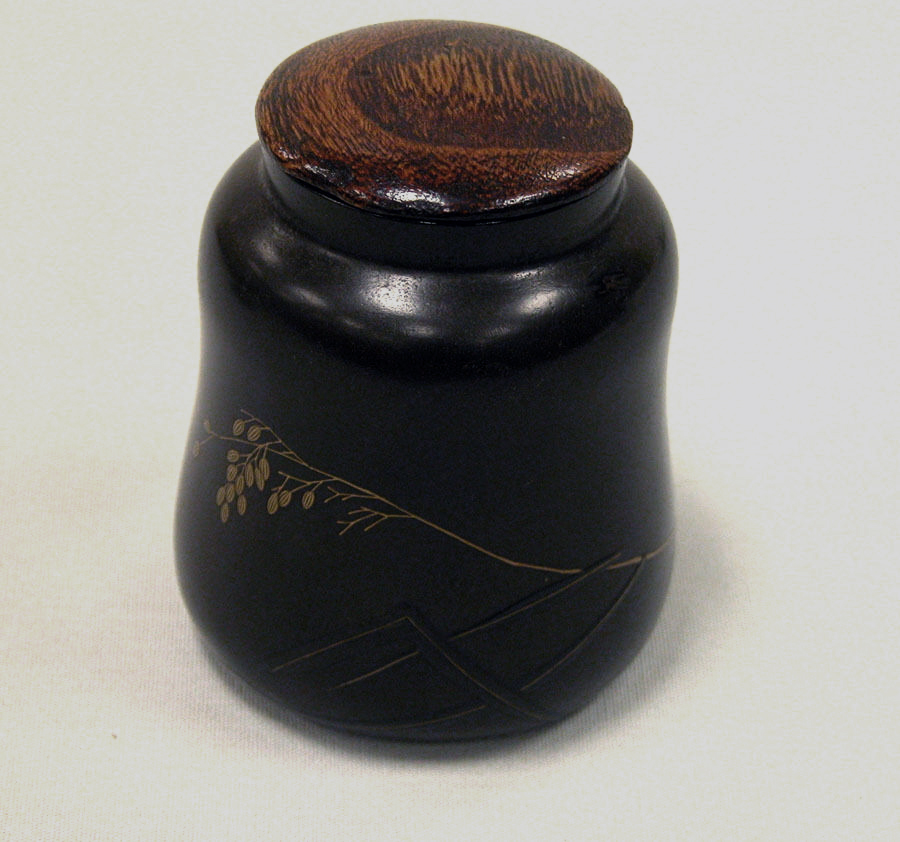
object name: tea caddy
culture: japanese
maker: shibata zeshin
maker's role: artist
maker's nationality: japanese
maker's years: 1807-1891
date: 1801-1900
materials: lacquer